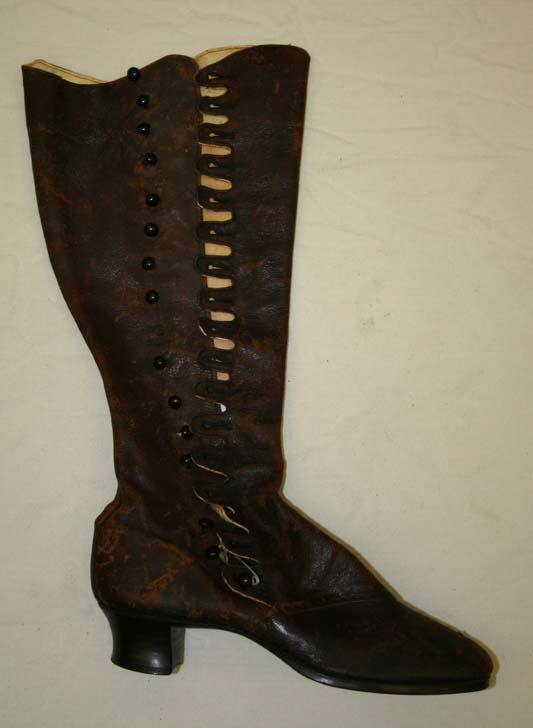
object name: boot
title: Boots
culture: american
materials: leather